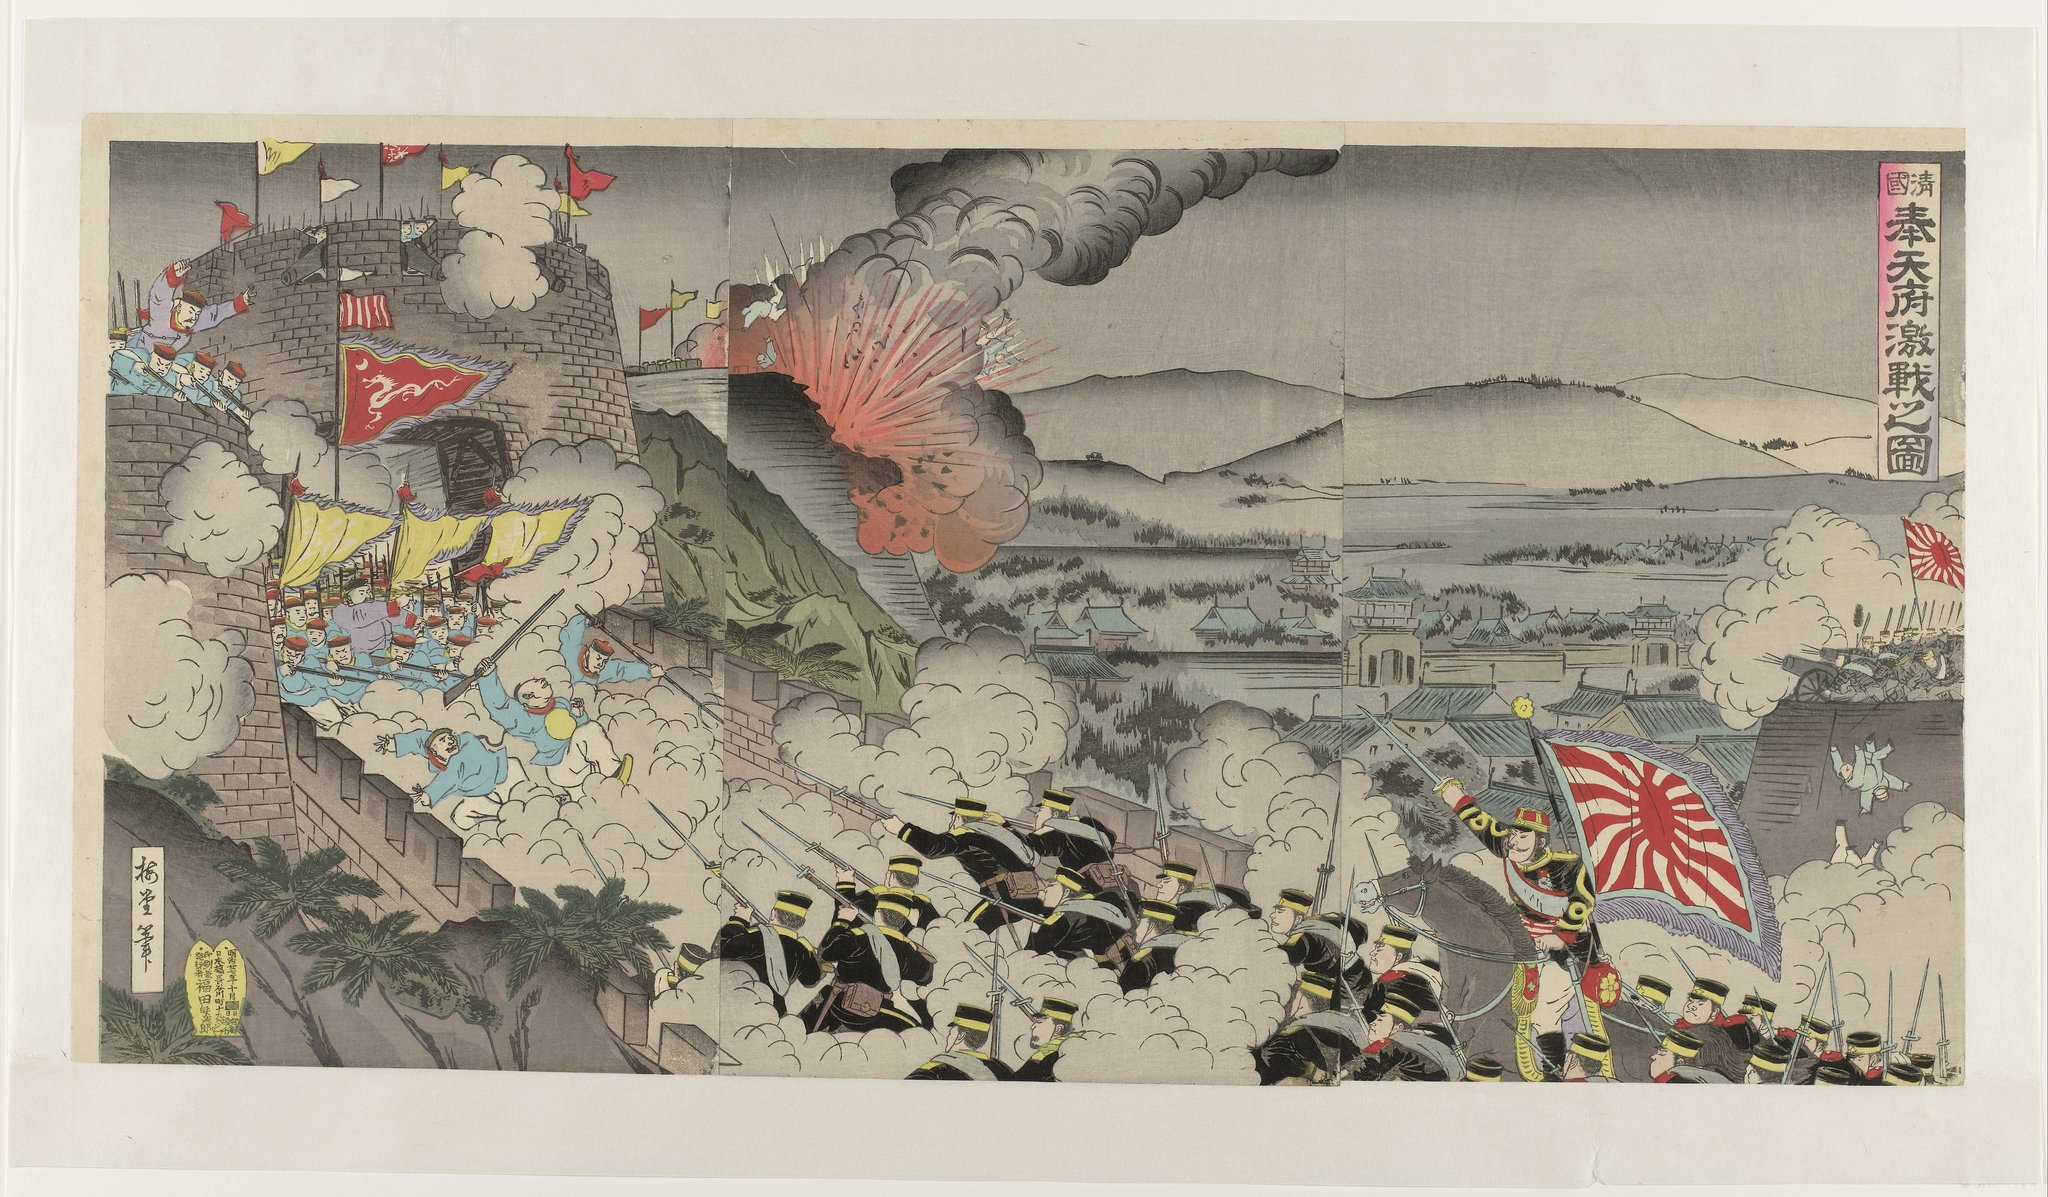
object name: print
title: Shinkoku Hôtenfu gekisen no zu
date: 1894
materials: paper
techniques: woodcut, polish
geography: japan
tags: breaking into city or fortress ~ siege, assault ~ siege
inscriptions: collector's mark: Lugt 2228, label:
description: Japanse soldaten in zwart winteruniform bestormen een vestiging in de Mukden provincie (hedendaags Liaoning) tijdens de Eerste Chinees-Japanse Oorlog (1894-1895).